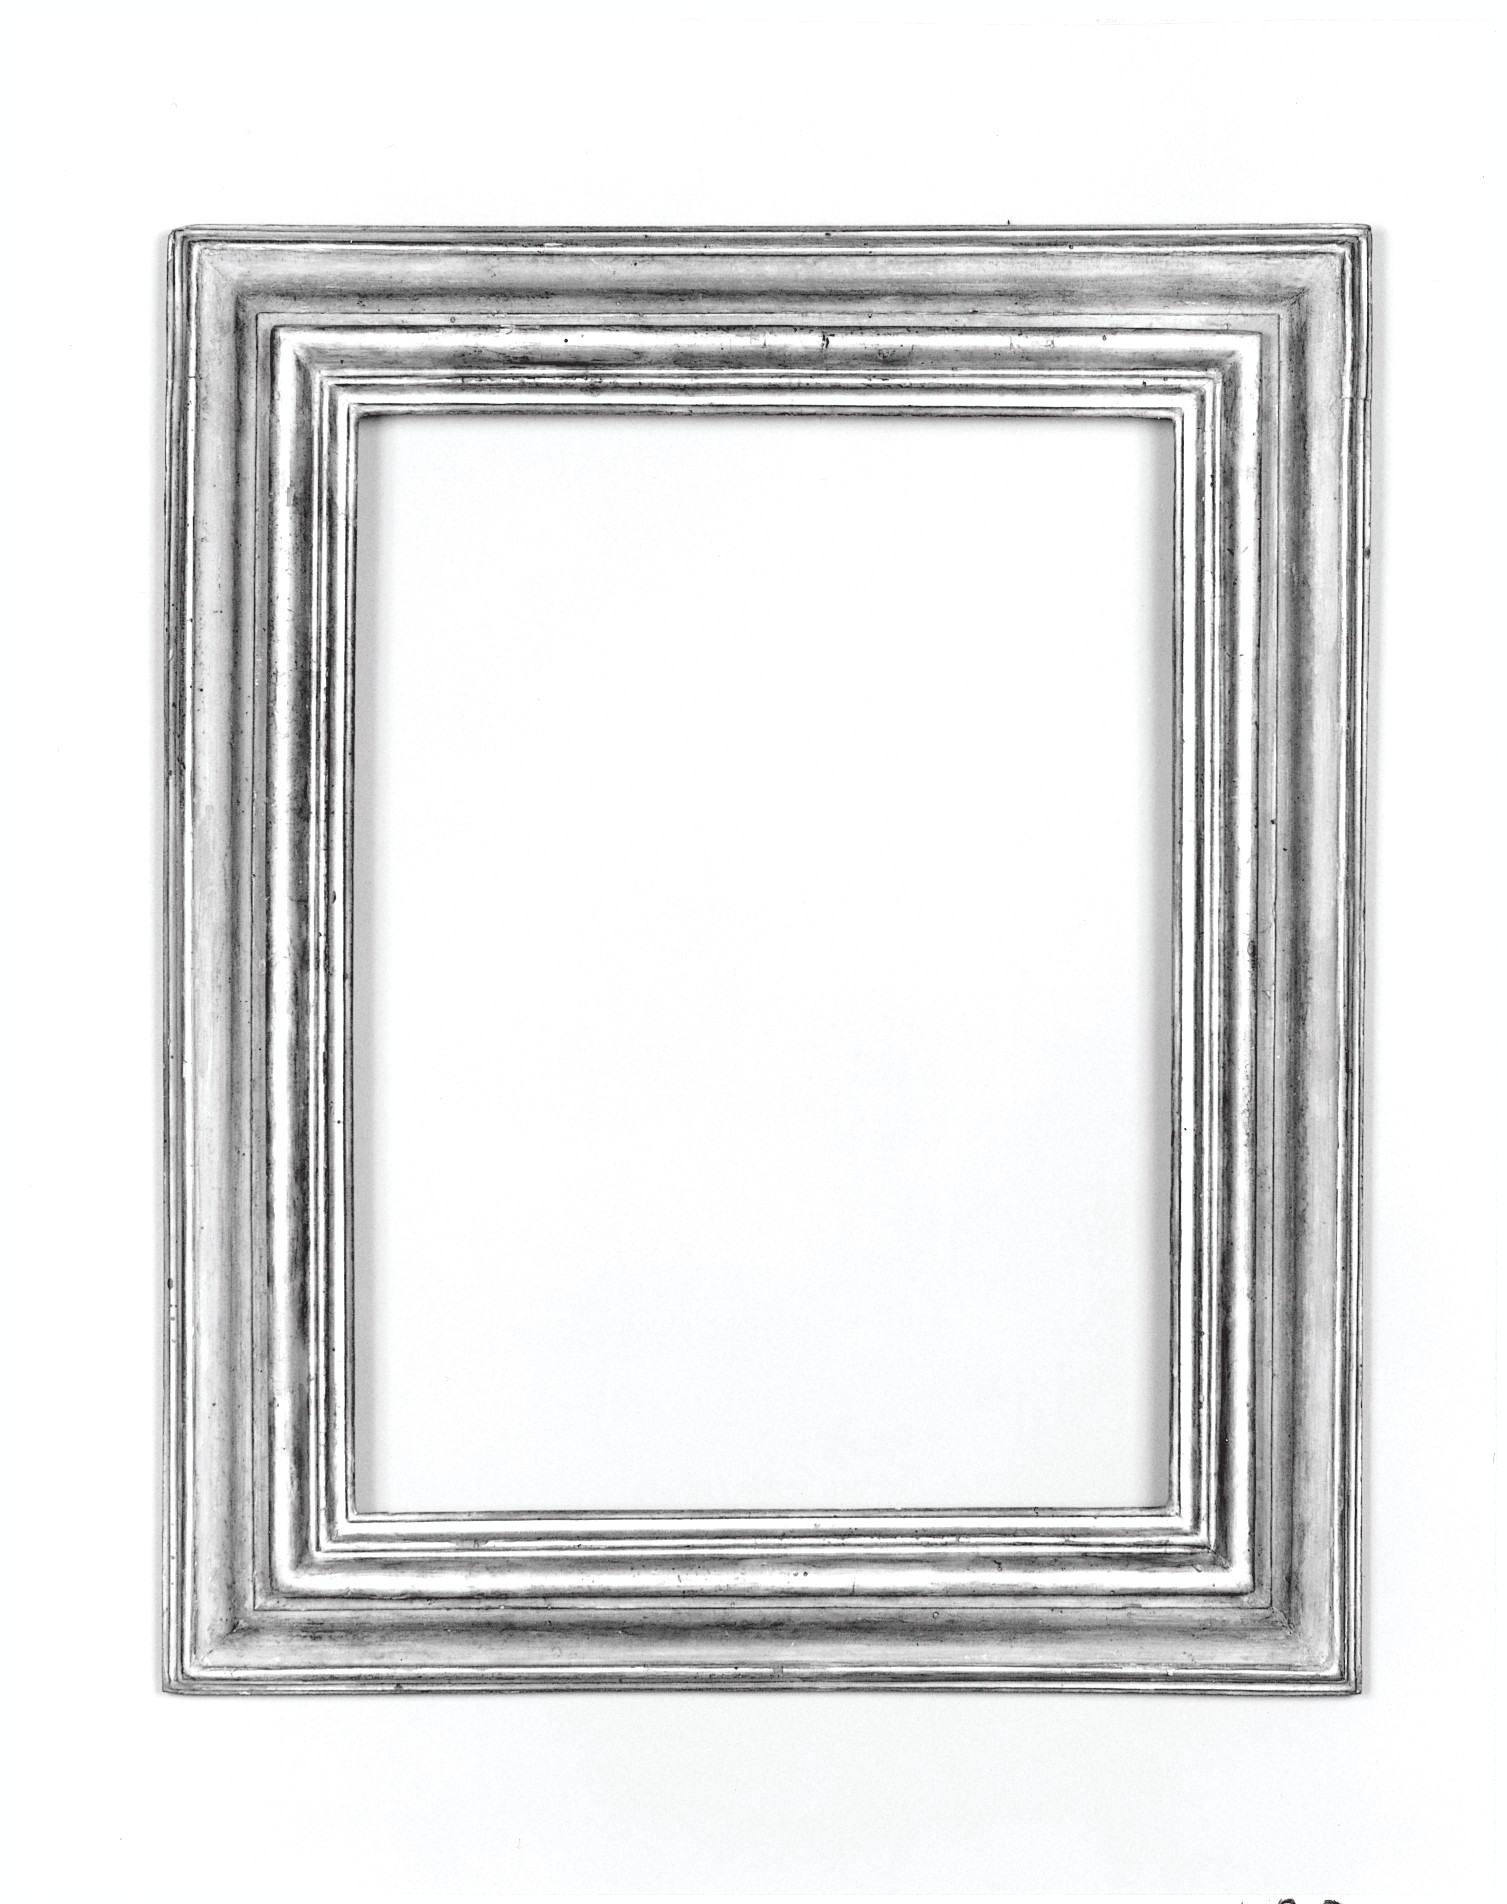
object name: frame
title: Reverse frame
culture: italian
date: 1680-1700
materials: wood